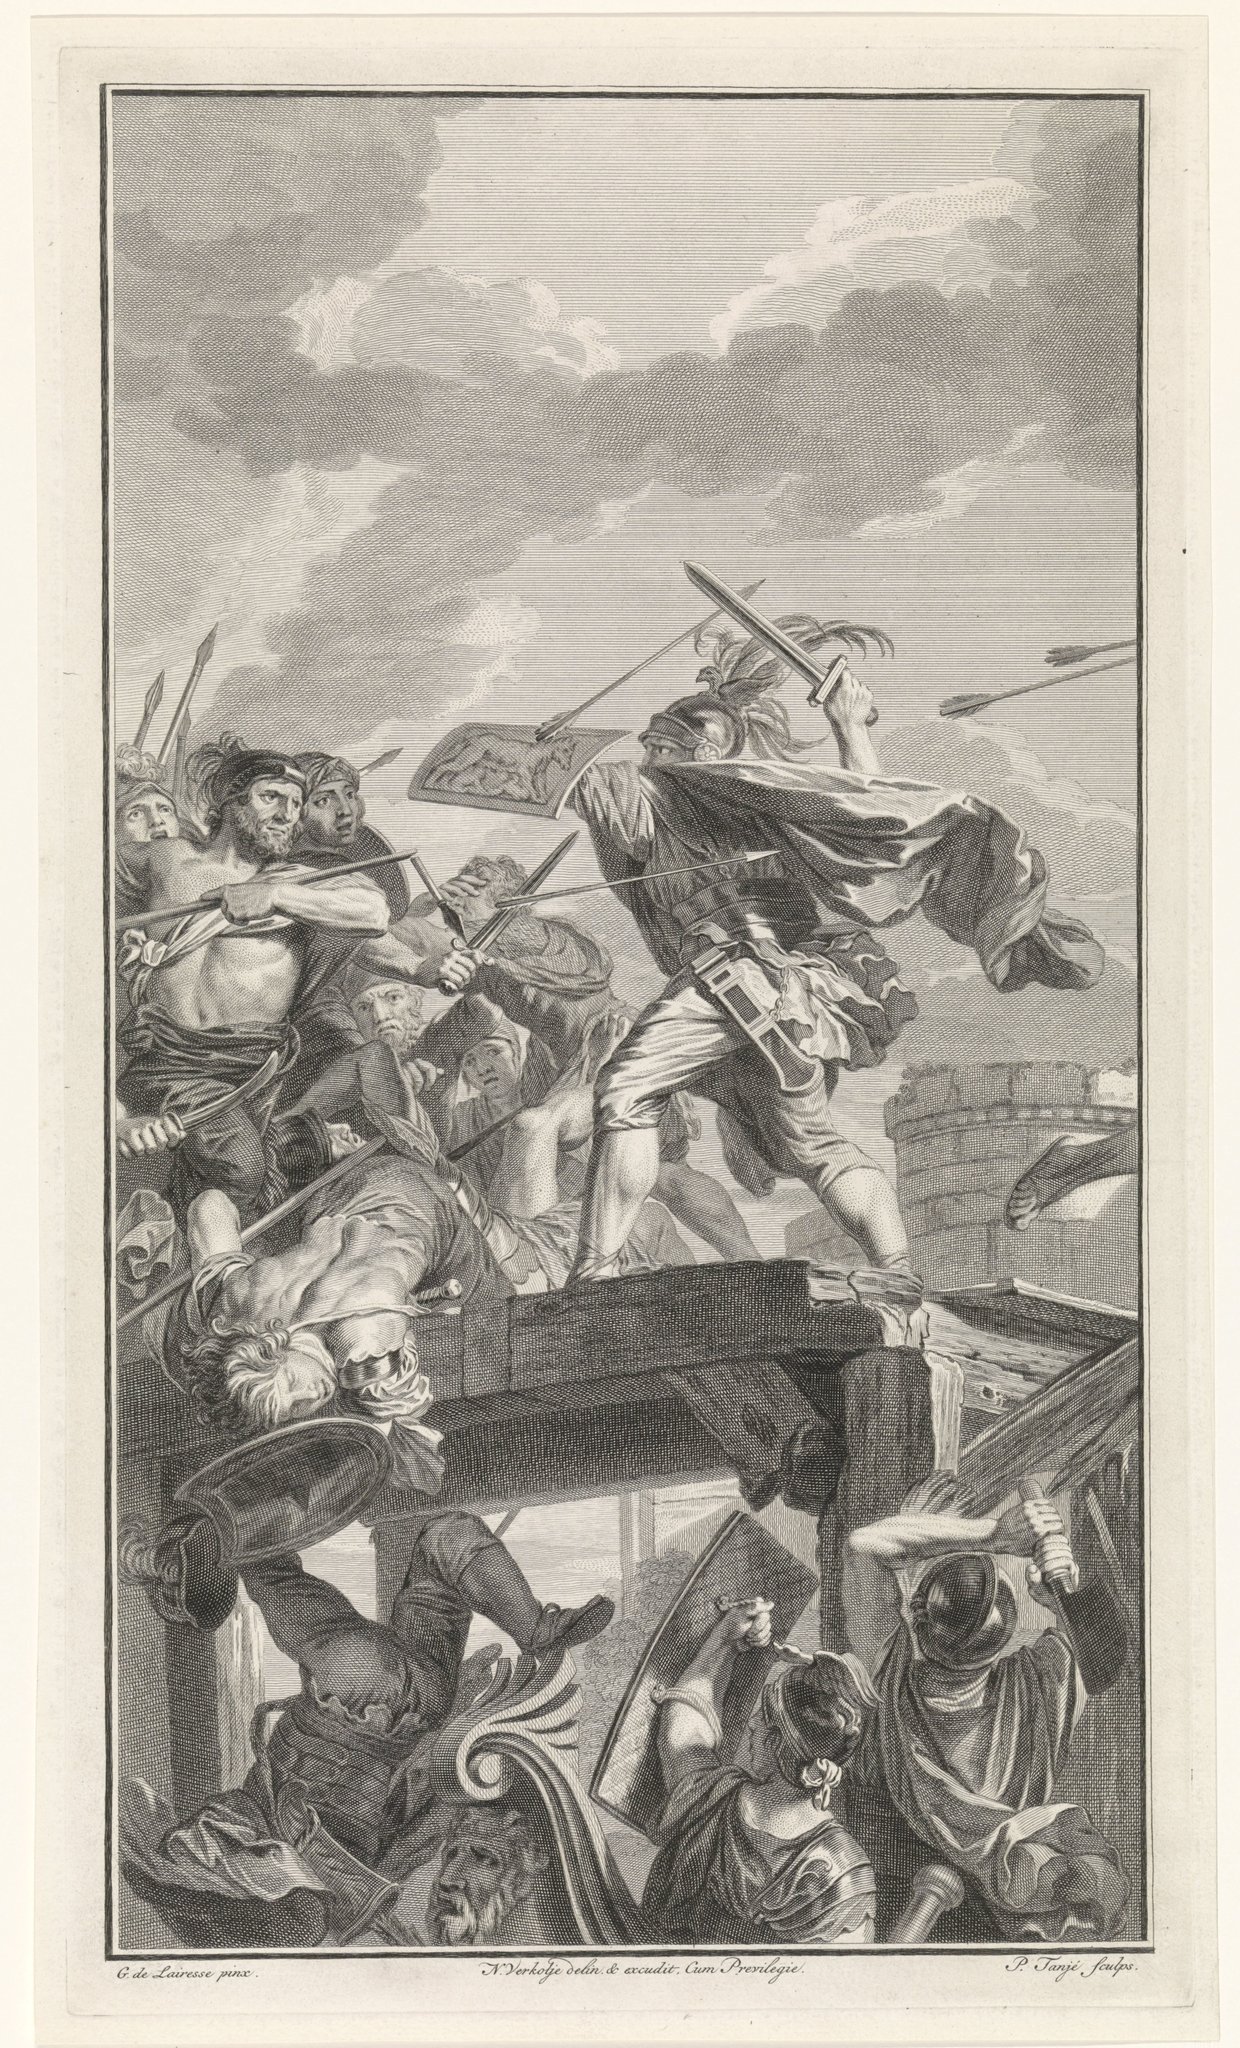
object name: print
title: Tafereelen, (...) in de raadkamer van den hove van justitie van Holland, Zeeland, en Westvriesland (...)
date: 1737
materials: paper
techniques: engraving, etching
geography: amsterdam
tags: horatius cocles at the pons sublicius: single-handed he keeps the etruscans at bay while the bridge is broken down by the romans behind him; he escapes by jumping into the tiber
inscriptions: collector's mark: Lugt 2228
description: Horatius Coclus voorkwam dat Rome werd veroverd door Etruskische troepen, door op op een houten brug over de Tiber de aanvallers af te weren. Achter hem breken Romeinse soldaten de brug af. Voorstelling in de Raadkamer van het Hof van Justitie van Holland, Zeeland en West-Friesland in het Binnenhof te Den Haag.